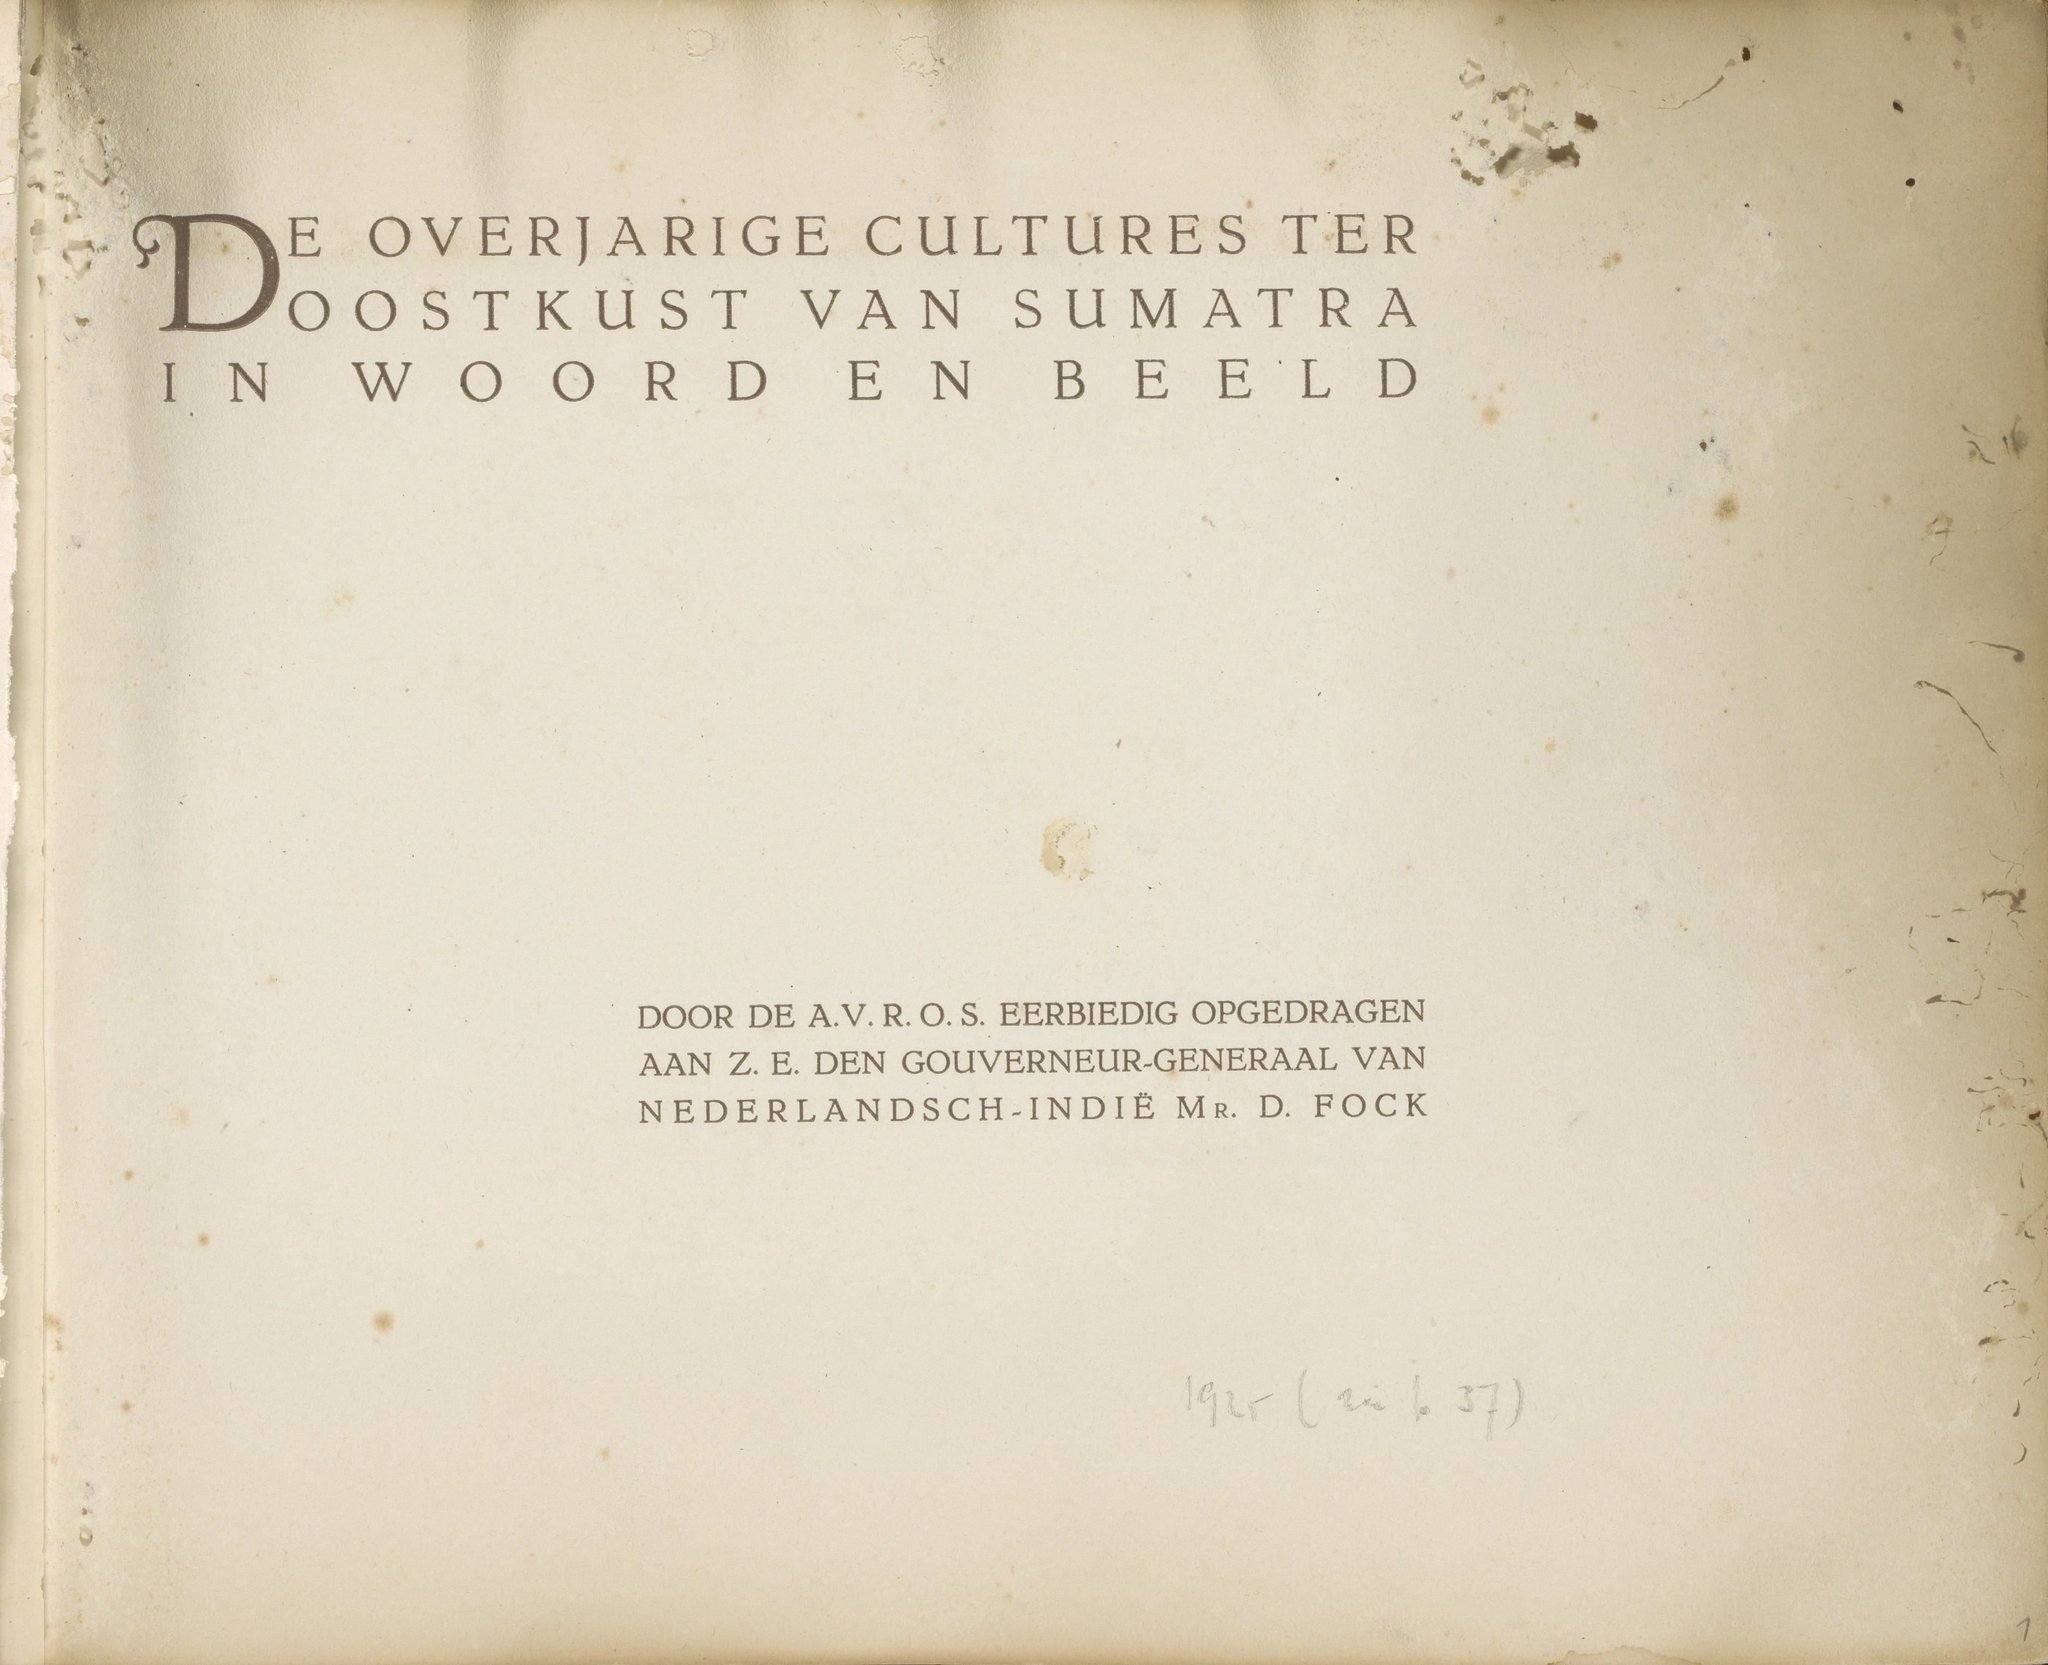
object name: titelblad, titelpagina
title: Titelpagina van De overjarige cultures ter oostkust van Sumatra in woord en beeld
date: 1924-1925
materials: paper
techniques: printing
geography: sumatra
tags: (non-fruit) products of plants or trees: rubber, sumatra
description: Onderdeel van een fotoboek van de Algemeene Vereeniging van Rubberplanters ter Oostkust van Sumatra (A.V.R.O.S.).